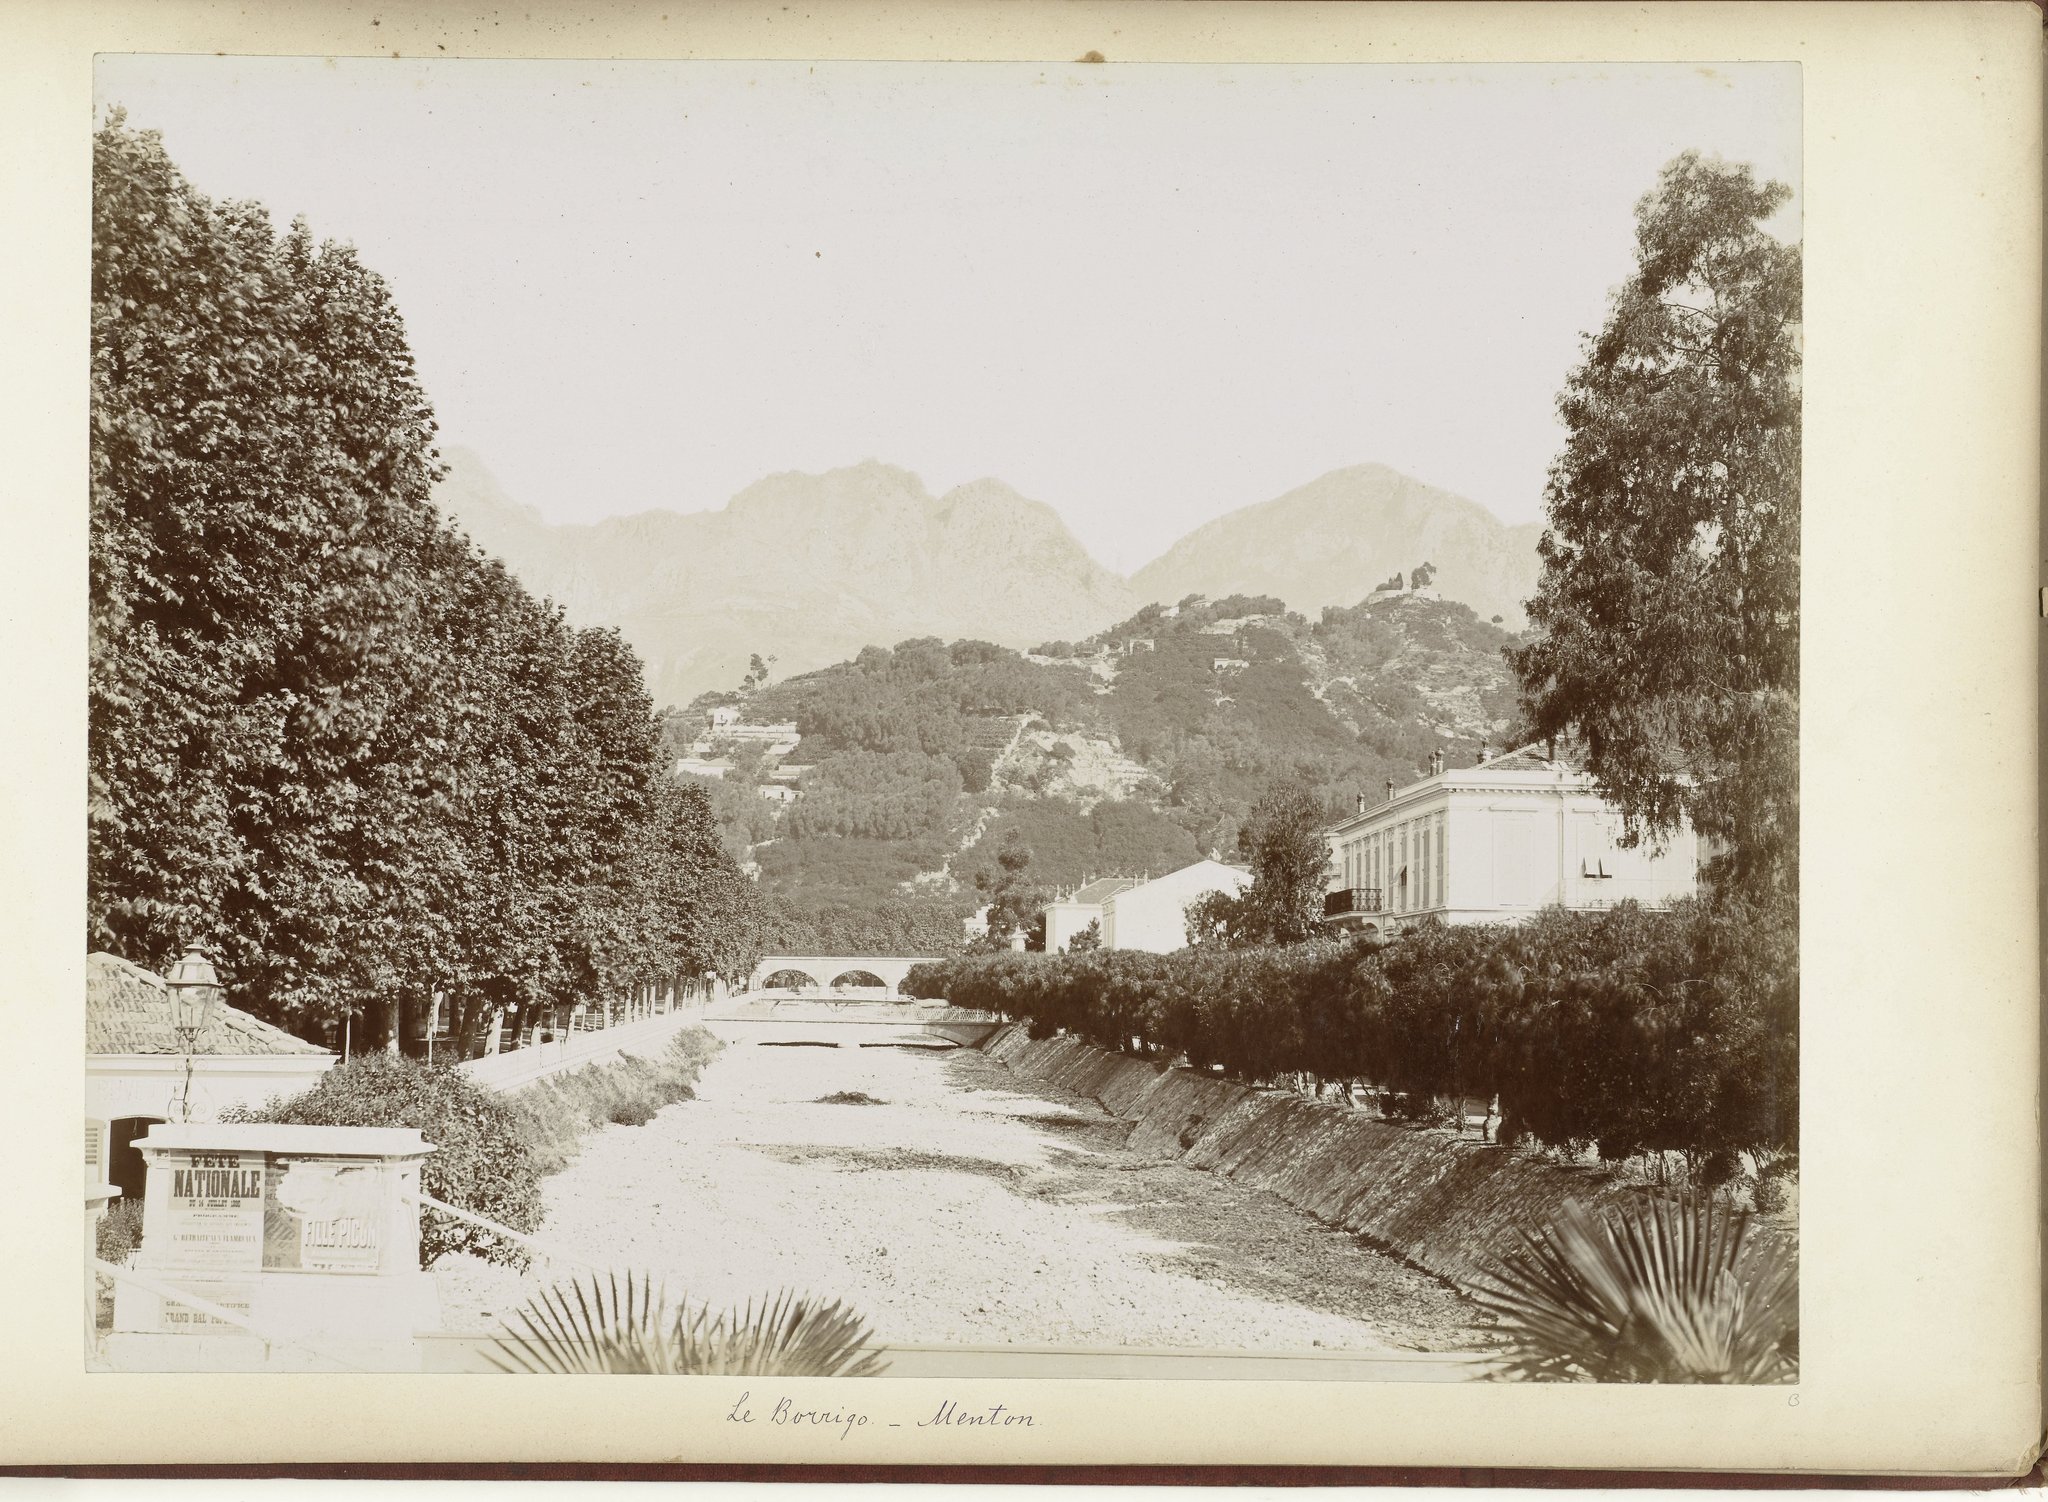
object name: photograph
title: Le Borrigo Menton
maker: henry pauw van wieldrecht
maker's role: fotograaf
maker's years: 1863-1912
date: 1886-1896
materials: cardboard, photographic support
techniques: albumen print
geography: france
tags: france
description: Een droogstaande rivier in het Borrigo dal van Menton.